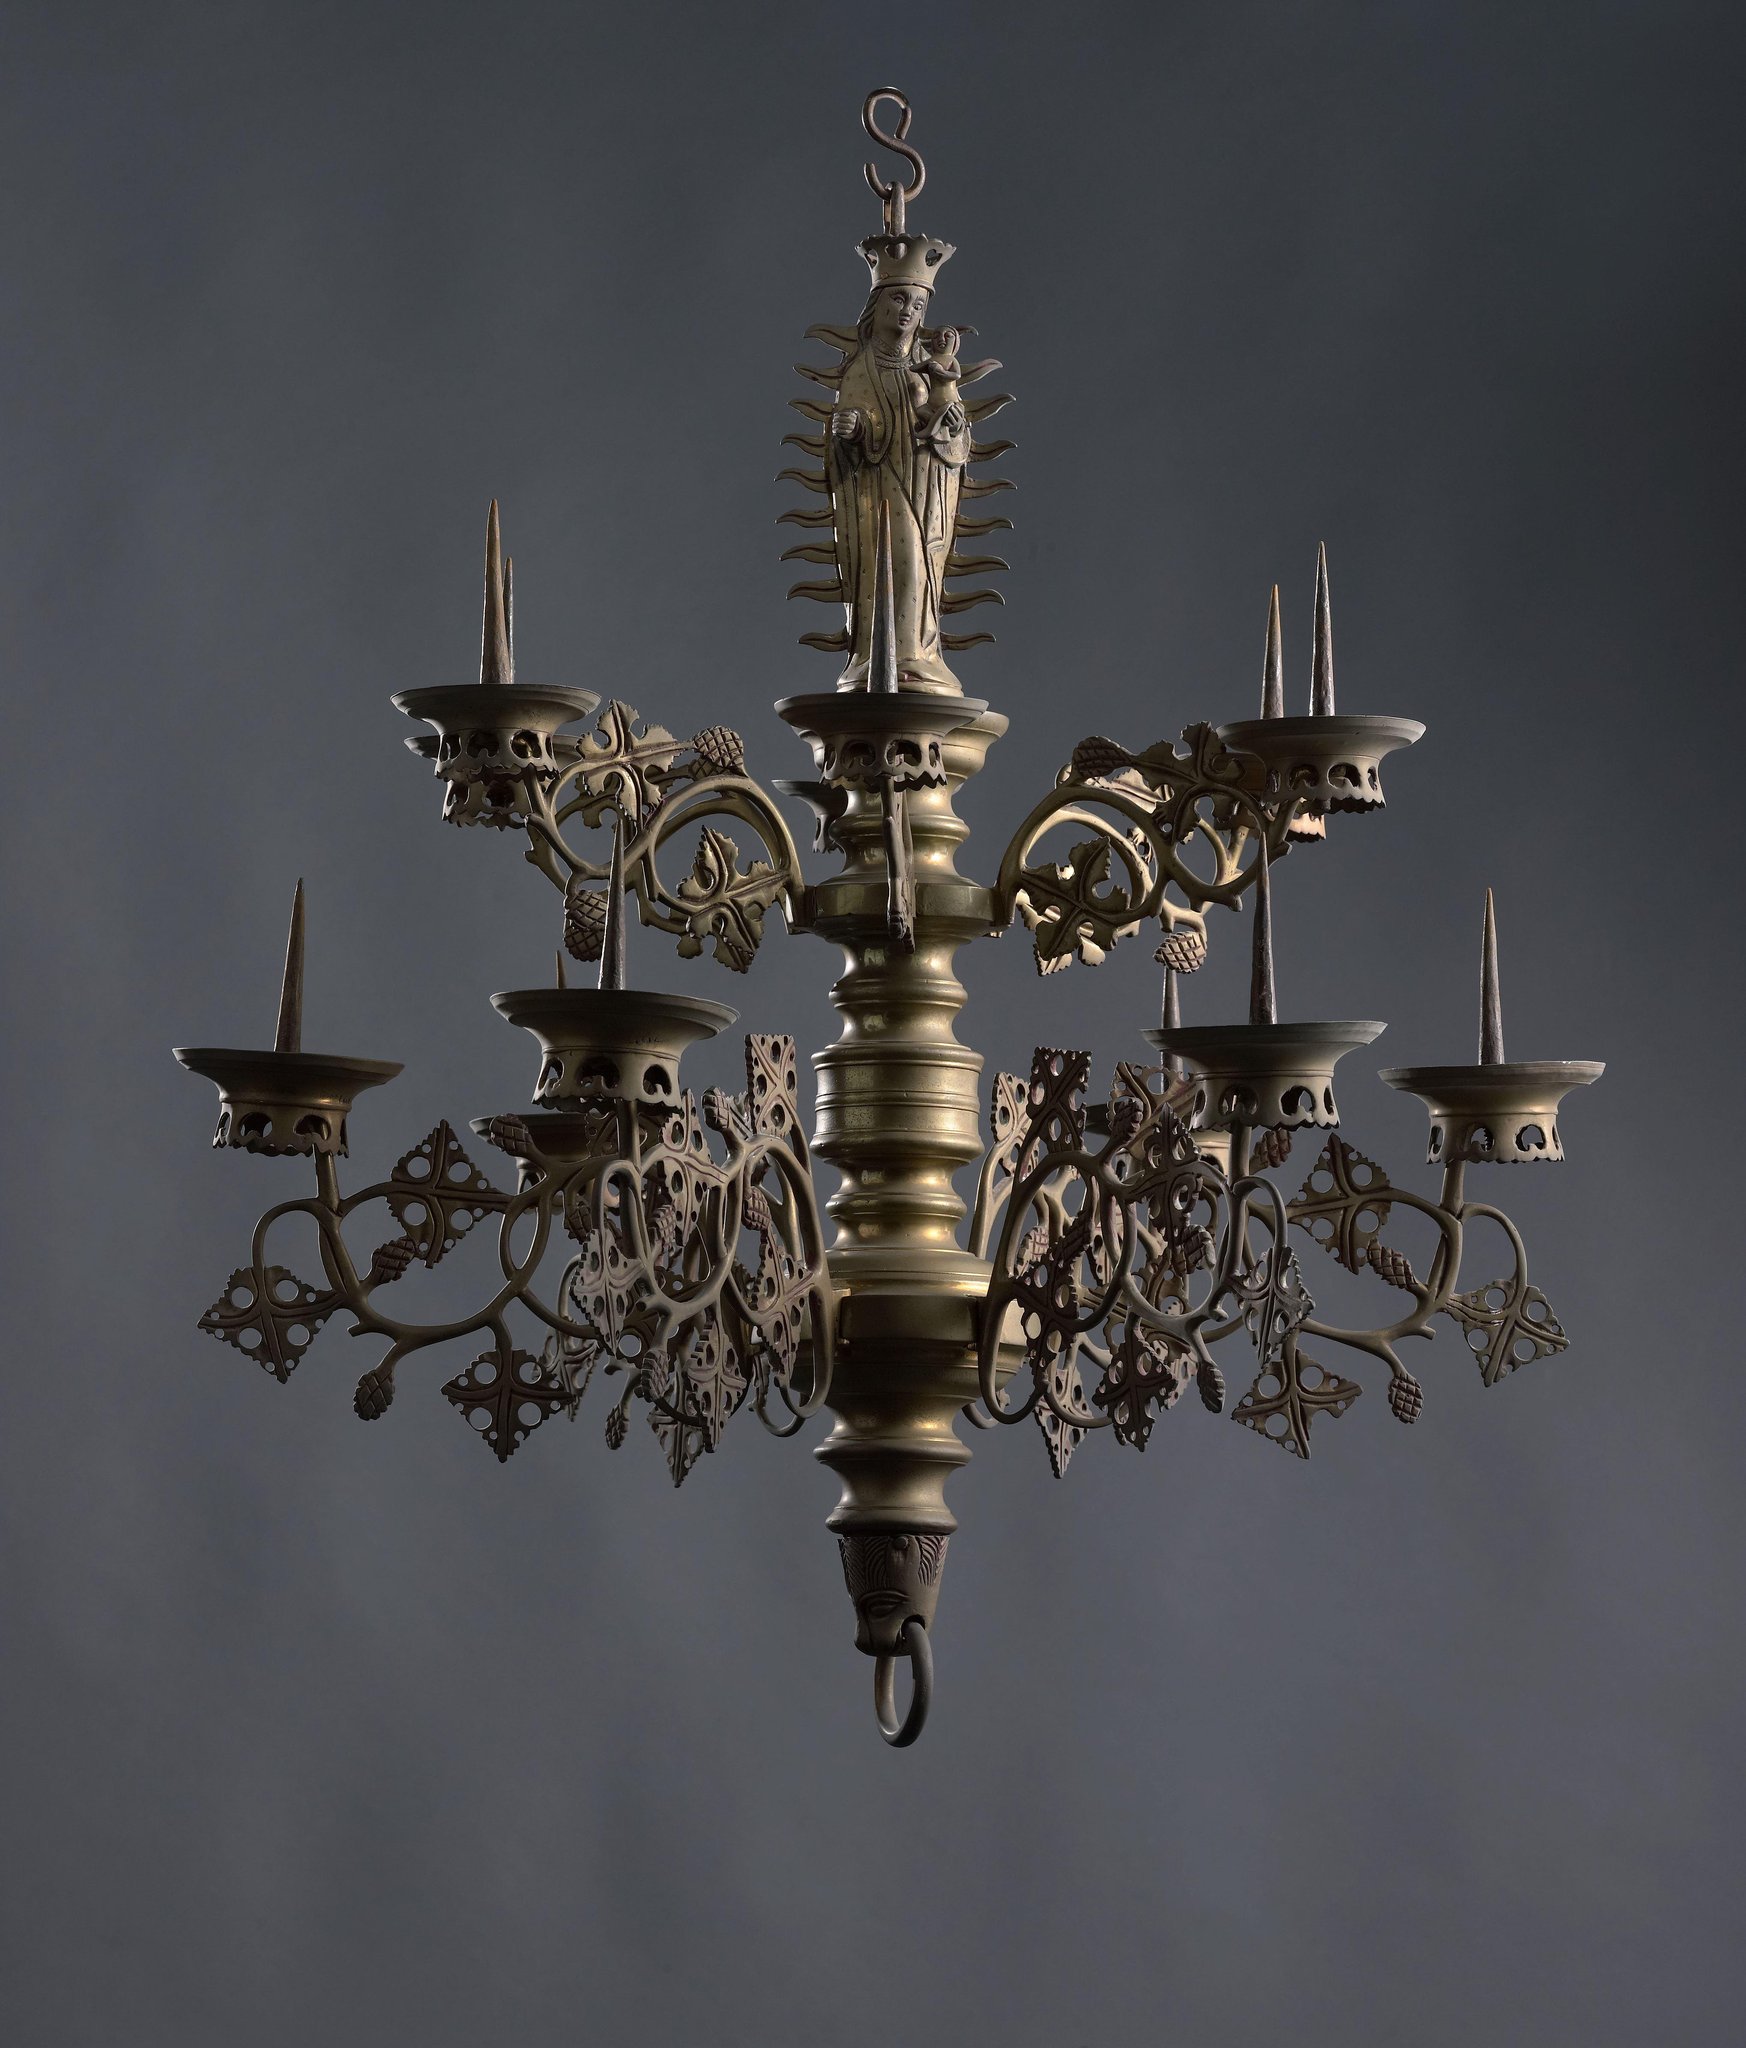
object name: chandelier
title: Arm met kaarsenhouder van kaarsenkroon van twee hoogten met ieder zes armen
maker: Anonymous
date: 1475-1500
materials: brass, iron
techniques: casting, metalworking, forging, screwed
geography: southern netherlands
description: Kaarsenarm behorende bij een kaarsenkroon van twee hoogten met Mariafiguur bovenaan. De arm is twee maal gebogen en is versierd met twee druiventrossen en twee wingerdbladeren. De ronde vetvanger heeft aan de onderkant opengewerkte, gekartelde verticaal geplaatste randen, ter maskering van de bevestiging op de arm. Dit geschiedt door een ronde ijzeren pin, die in het einde van de arm is geschroefd. Dit is de eerste arm van de bovenste ring, genummerd met 1 verticale inkeping. De vetvanger is genummerd met 1 verticale inkeping.